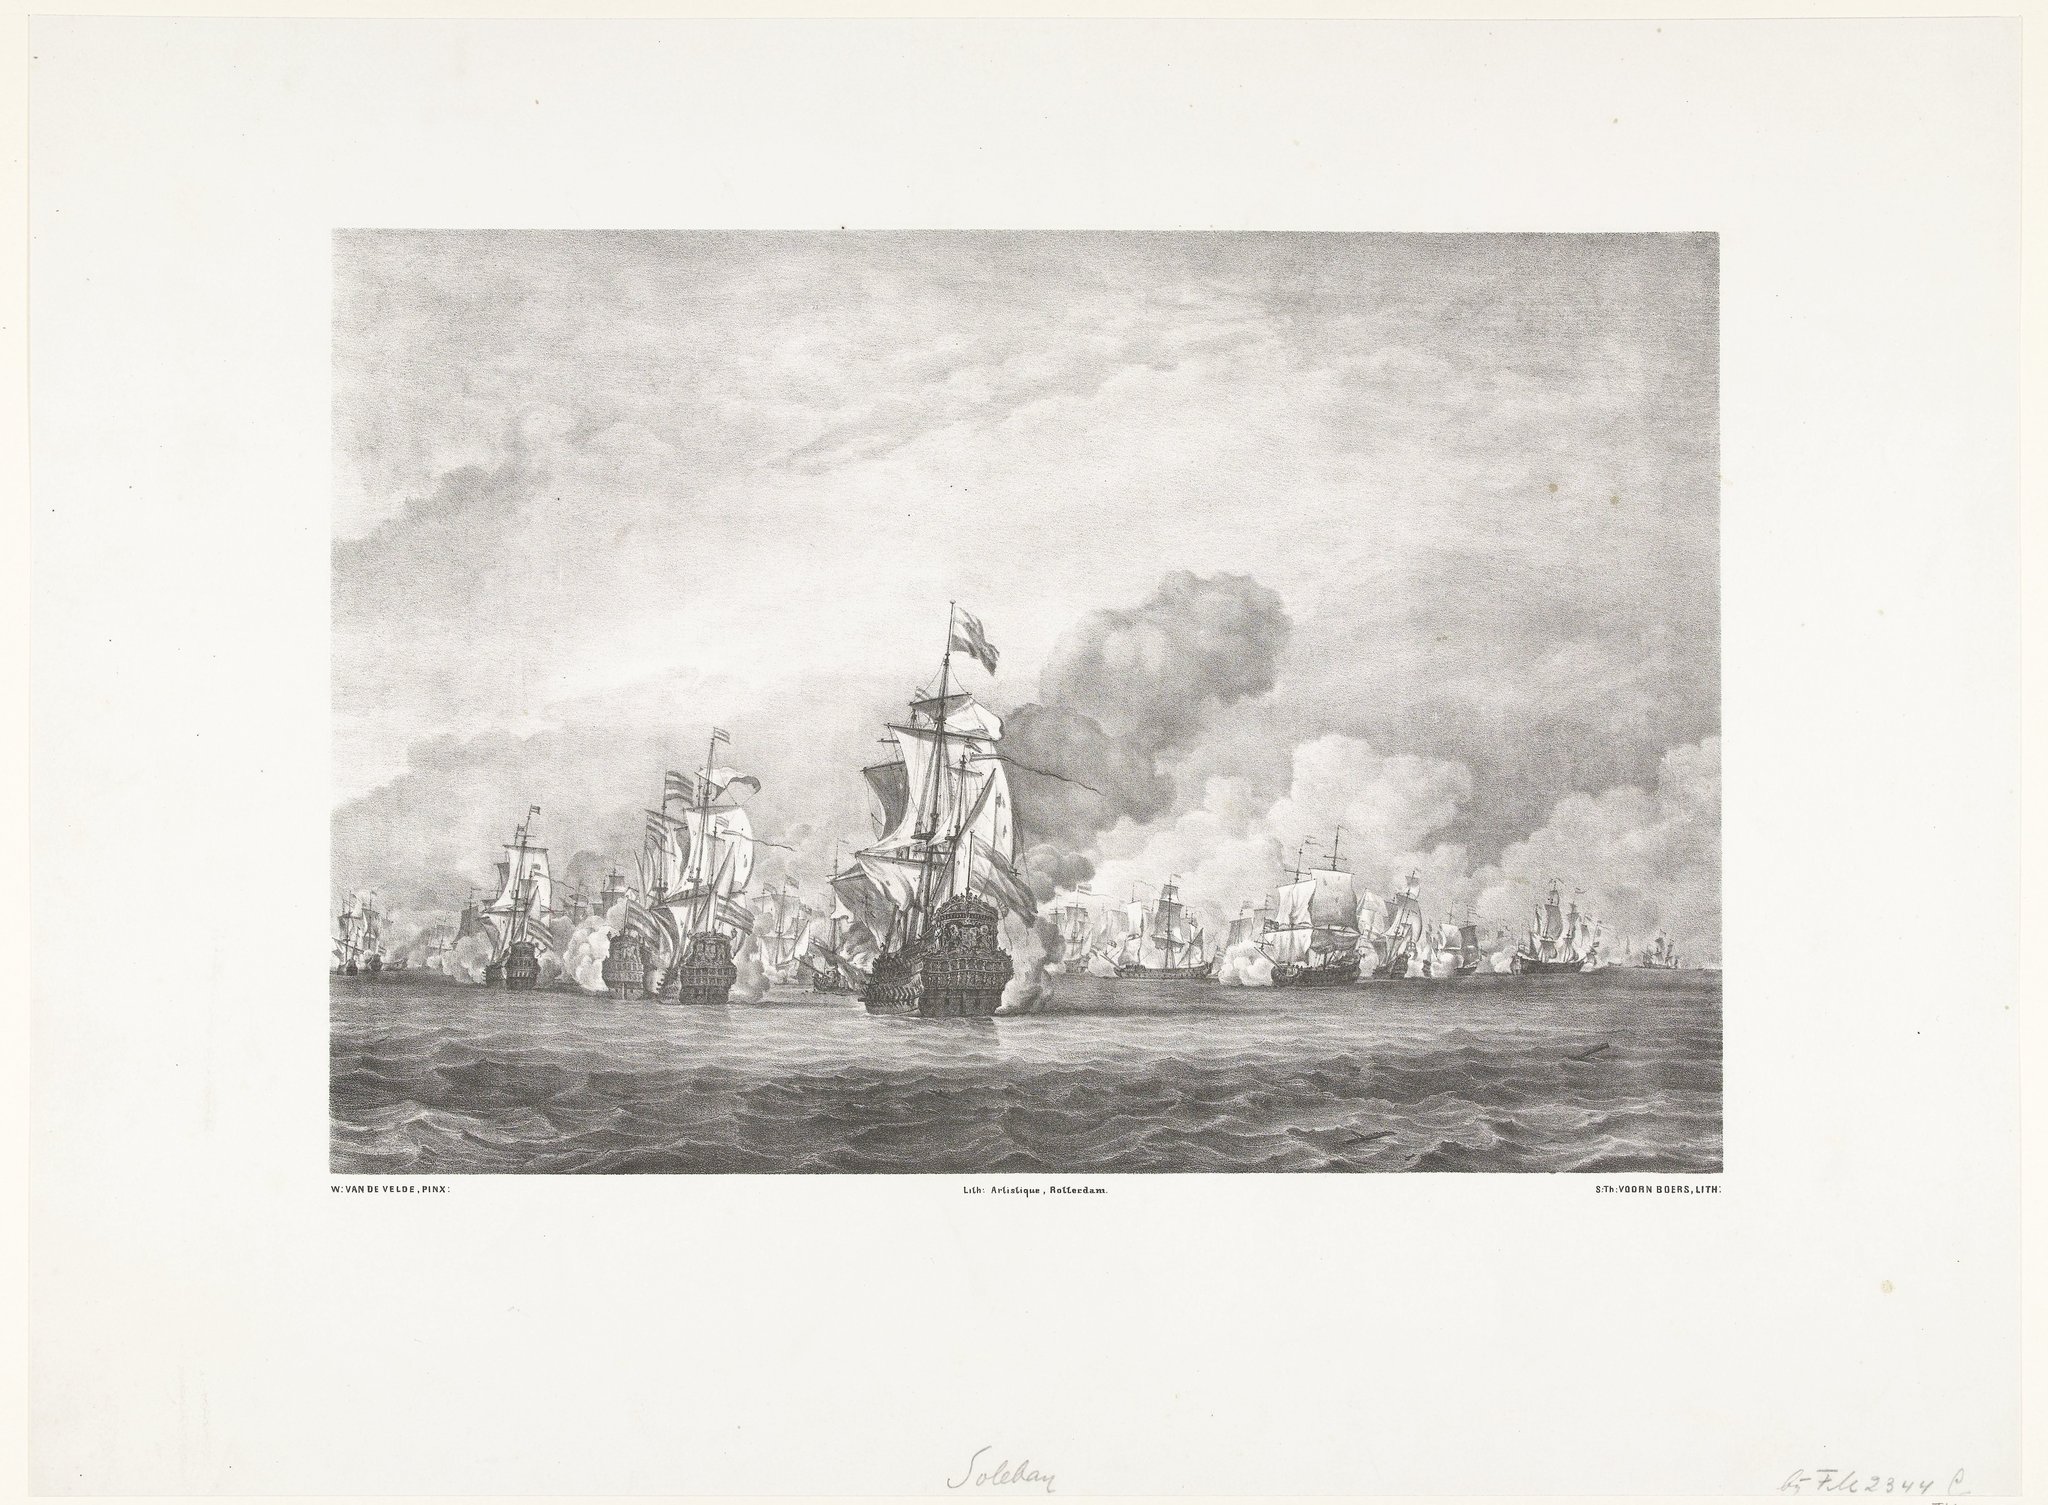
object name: history print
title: Slag bij Solebay, 7 juni 1672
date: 1838-1893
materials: paper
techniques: lithograph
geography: rotterdam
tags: flushing, michiel adriaenszoon de ruyter, jacobus ii (koning van engeland en schotland), battle (+ naval force), battle of solebay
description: De slag bij Solebay op 7 juni 1672 tussen de Staatse vloot onder Michiel Adriaenszoon de Ruyter en de Engels-Franse vloot onder de hertog van York en de vice-admiraal Jean II d'Estrees.